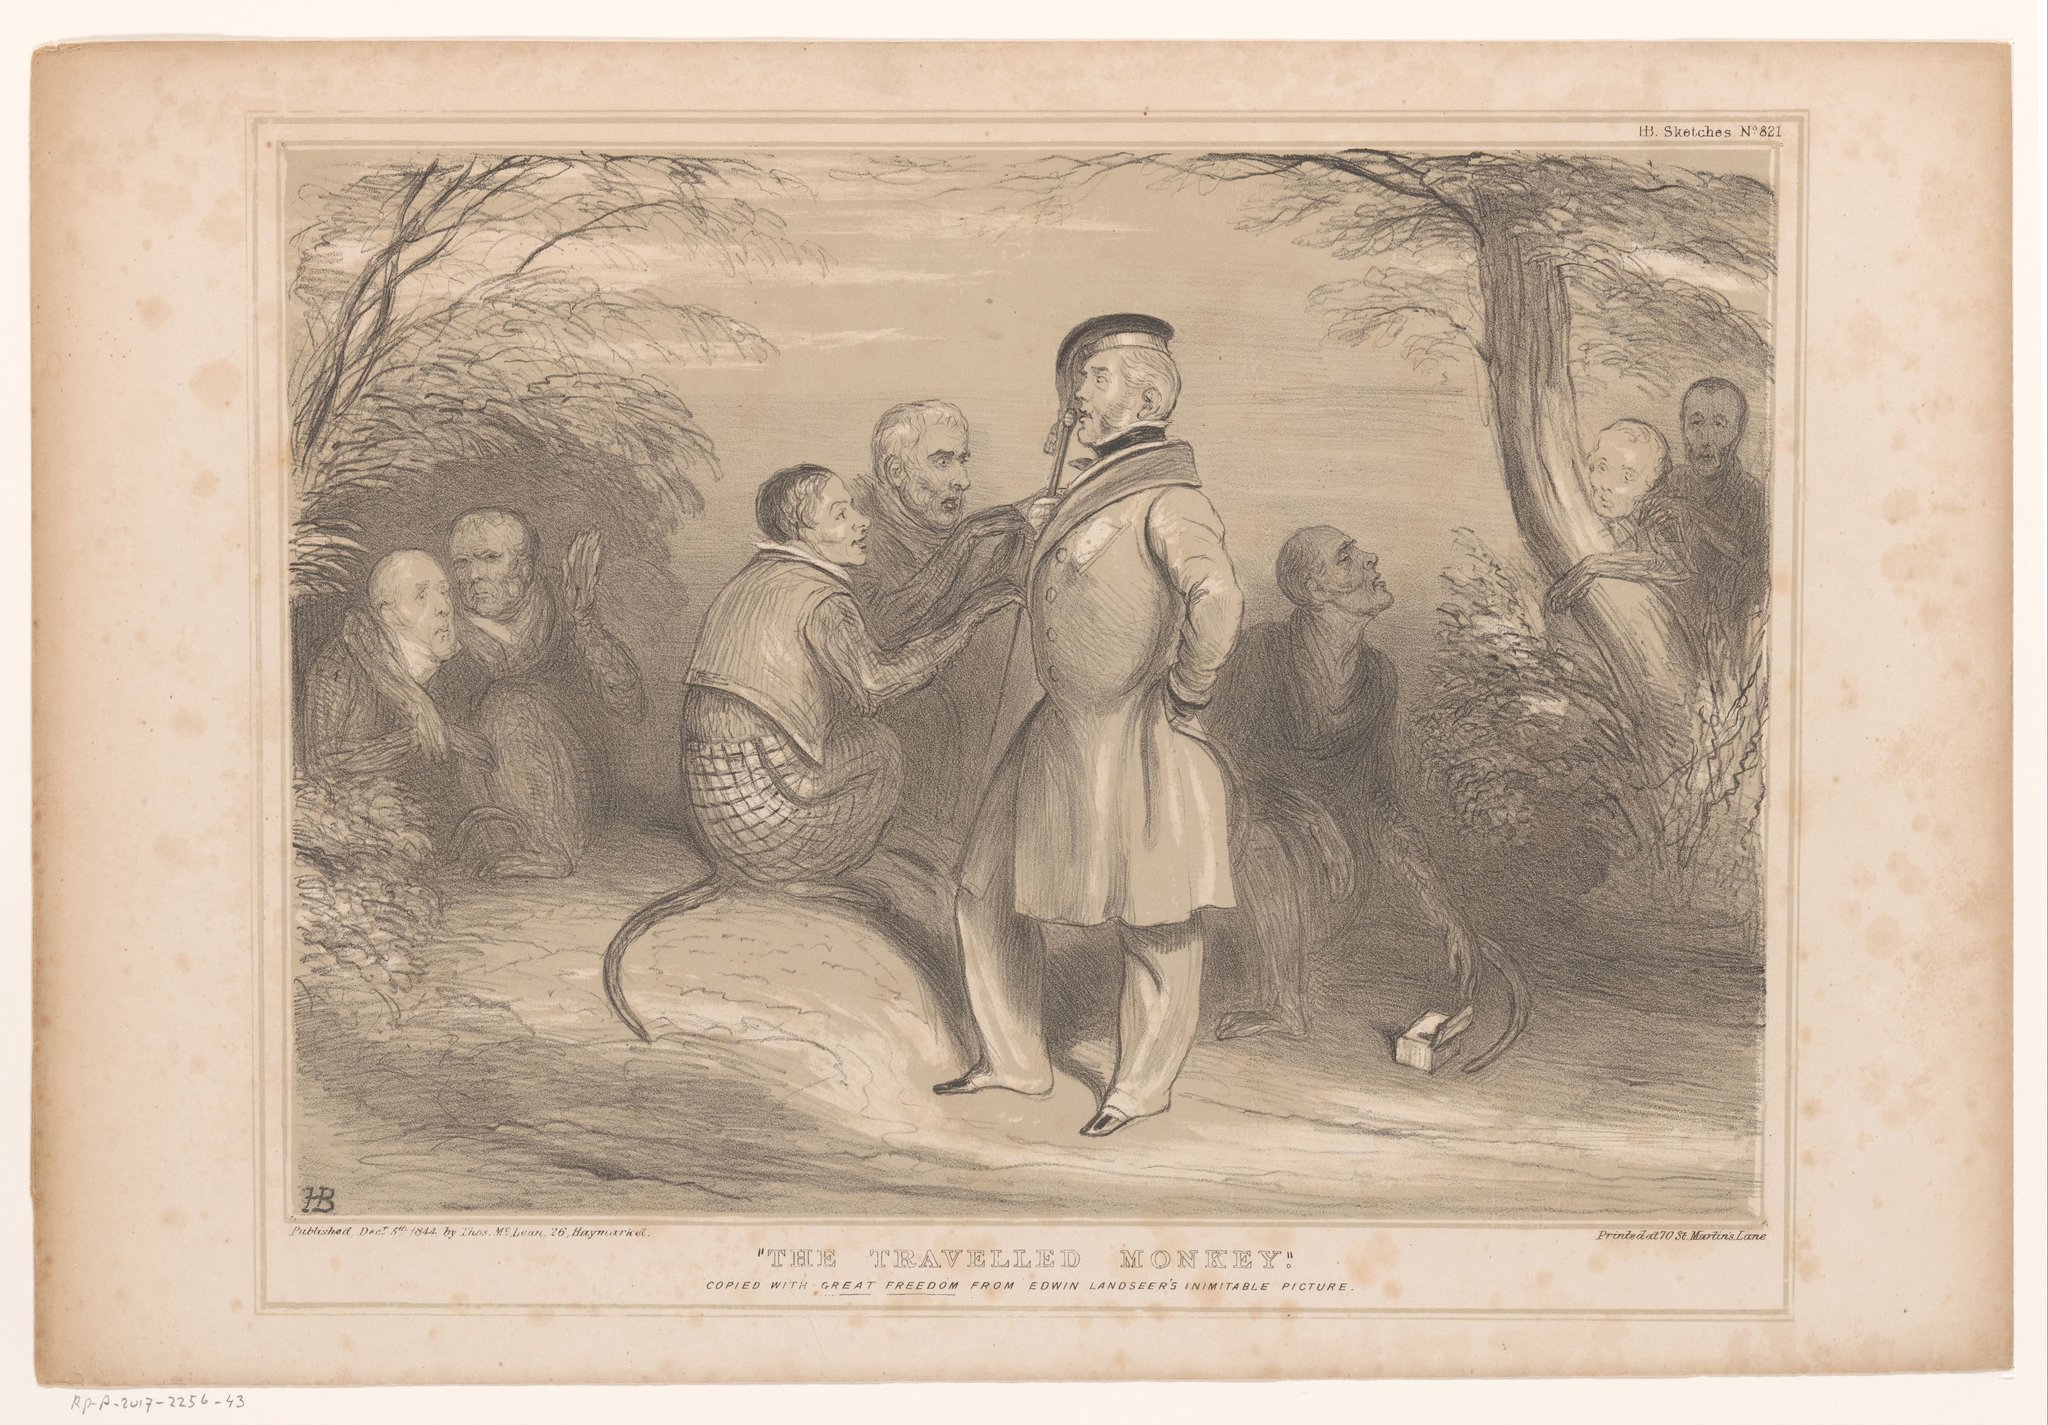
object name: cartoon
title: HB Sketches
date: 1844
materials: paper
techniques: tone lithography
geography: england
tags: monkeys, apes, political caricatures and satires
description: Spotprent uit 1844 met Lord Palmerston als reiziger terug tussen apen met hoofden van politici. Uitgegeven als nr. 821 in de serie HB Sketches.